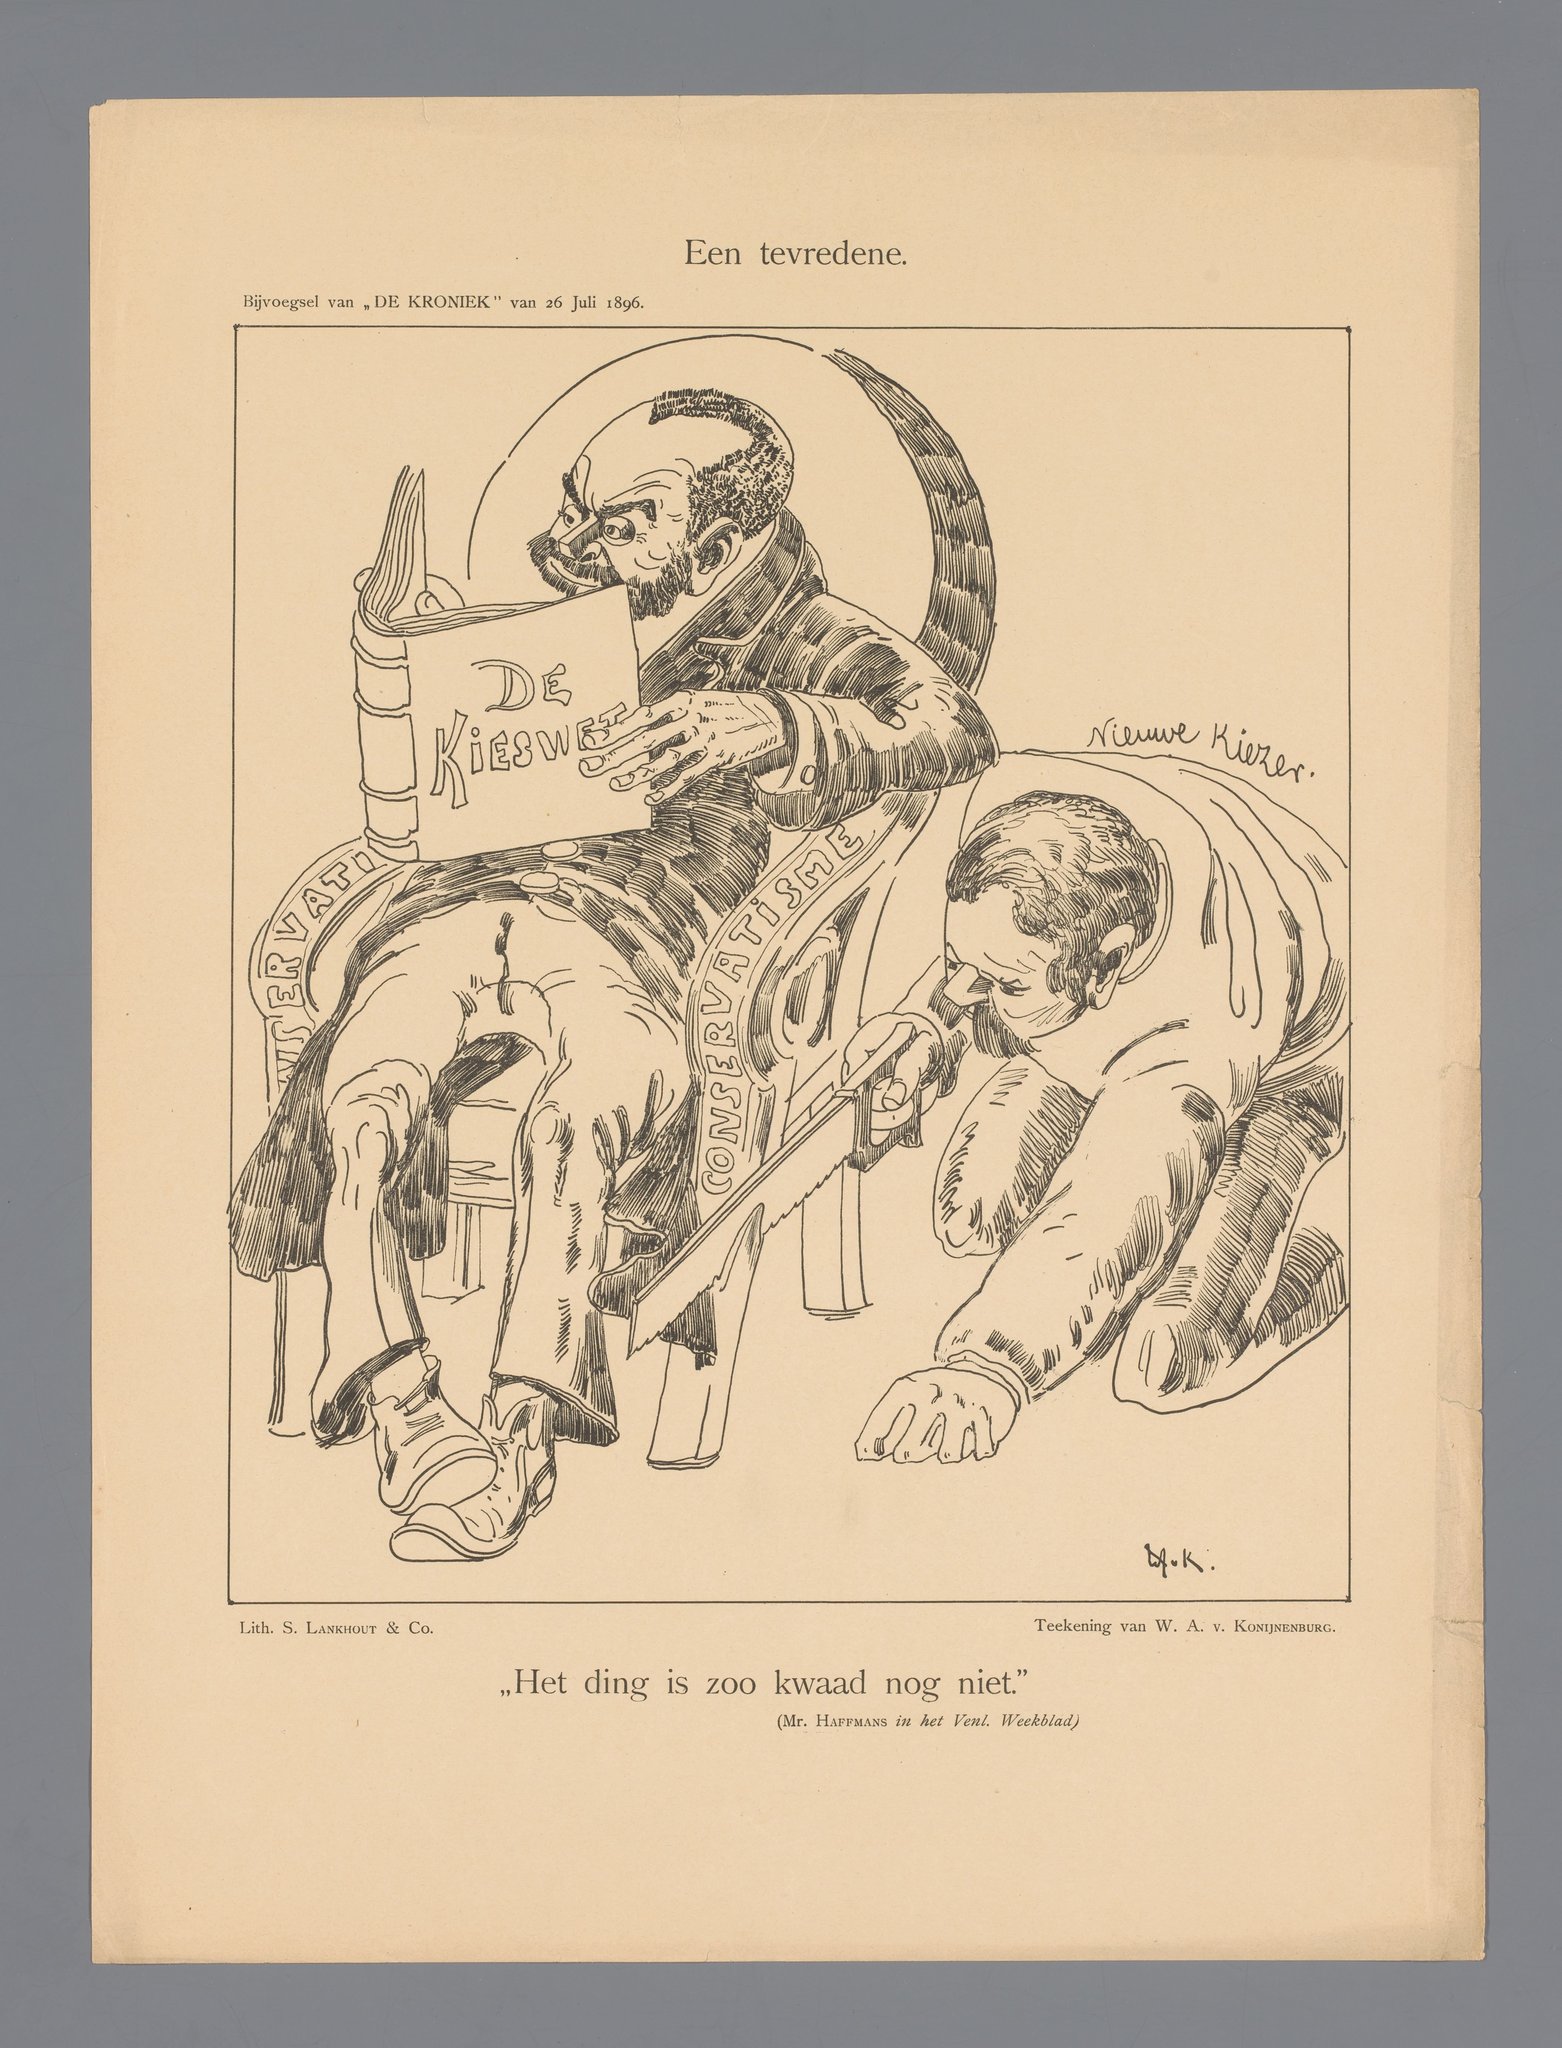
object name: cartoon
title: Een tevredene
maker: willem van konijnenburg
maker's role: draughtsman, painter, print maker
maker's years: 1868-1943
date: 1896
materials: paper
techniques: lithograph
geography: the hague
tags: voting, election, historical persons, politician, e.g. party leader, political caricatures and satires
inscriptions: date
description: Prent uit het bijvoegsel van: De Kroniek 2 (1896), 26 juli 1896.